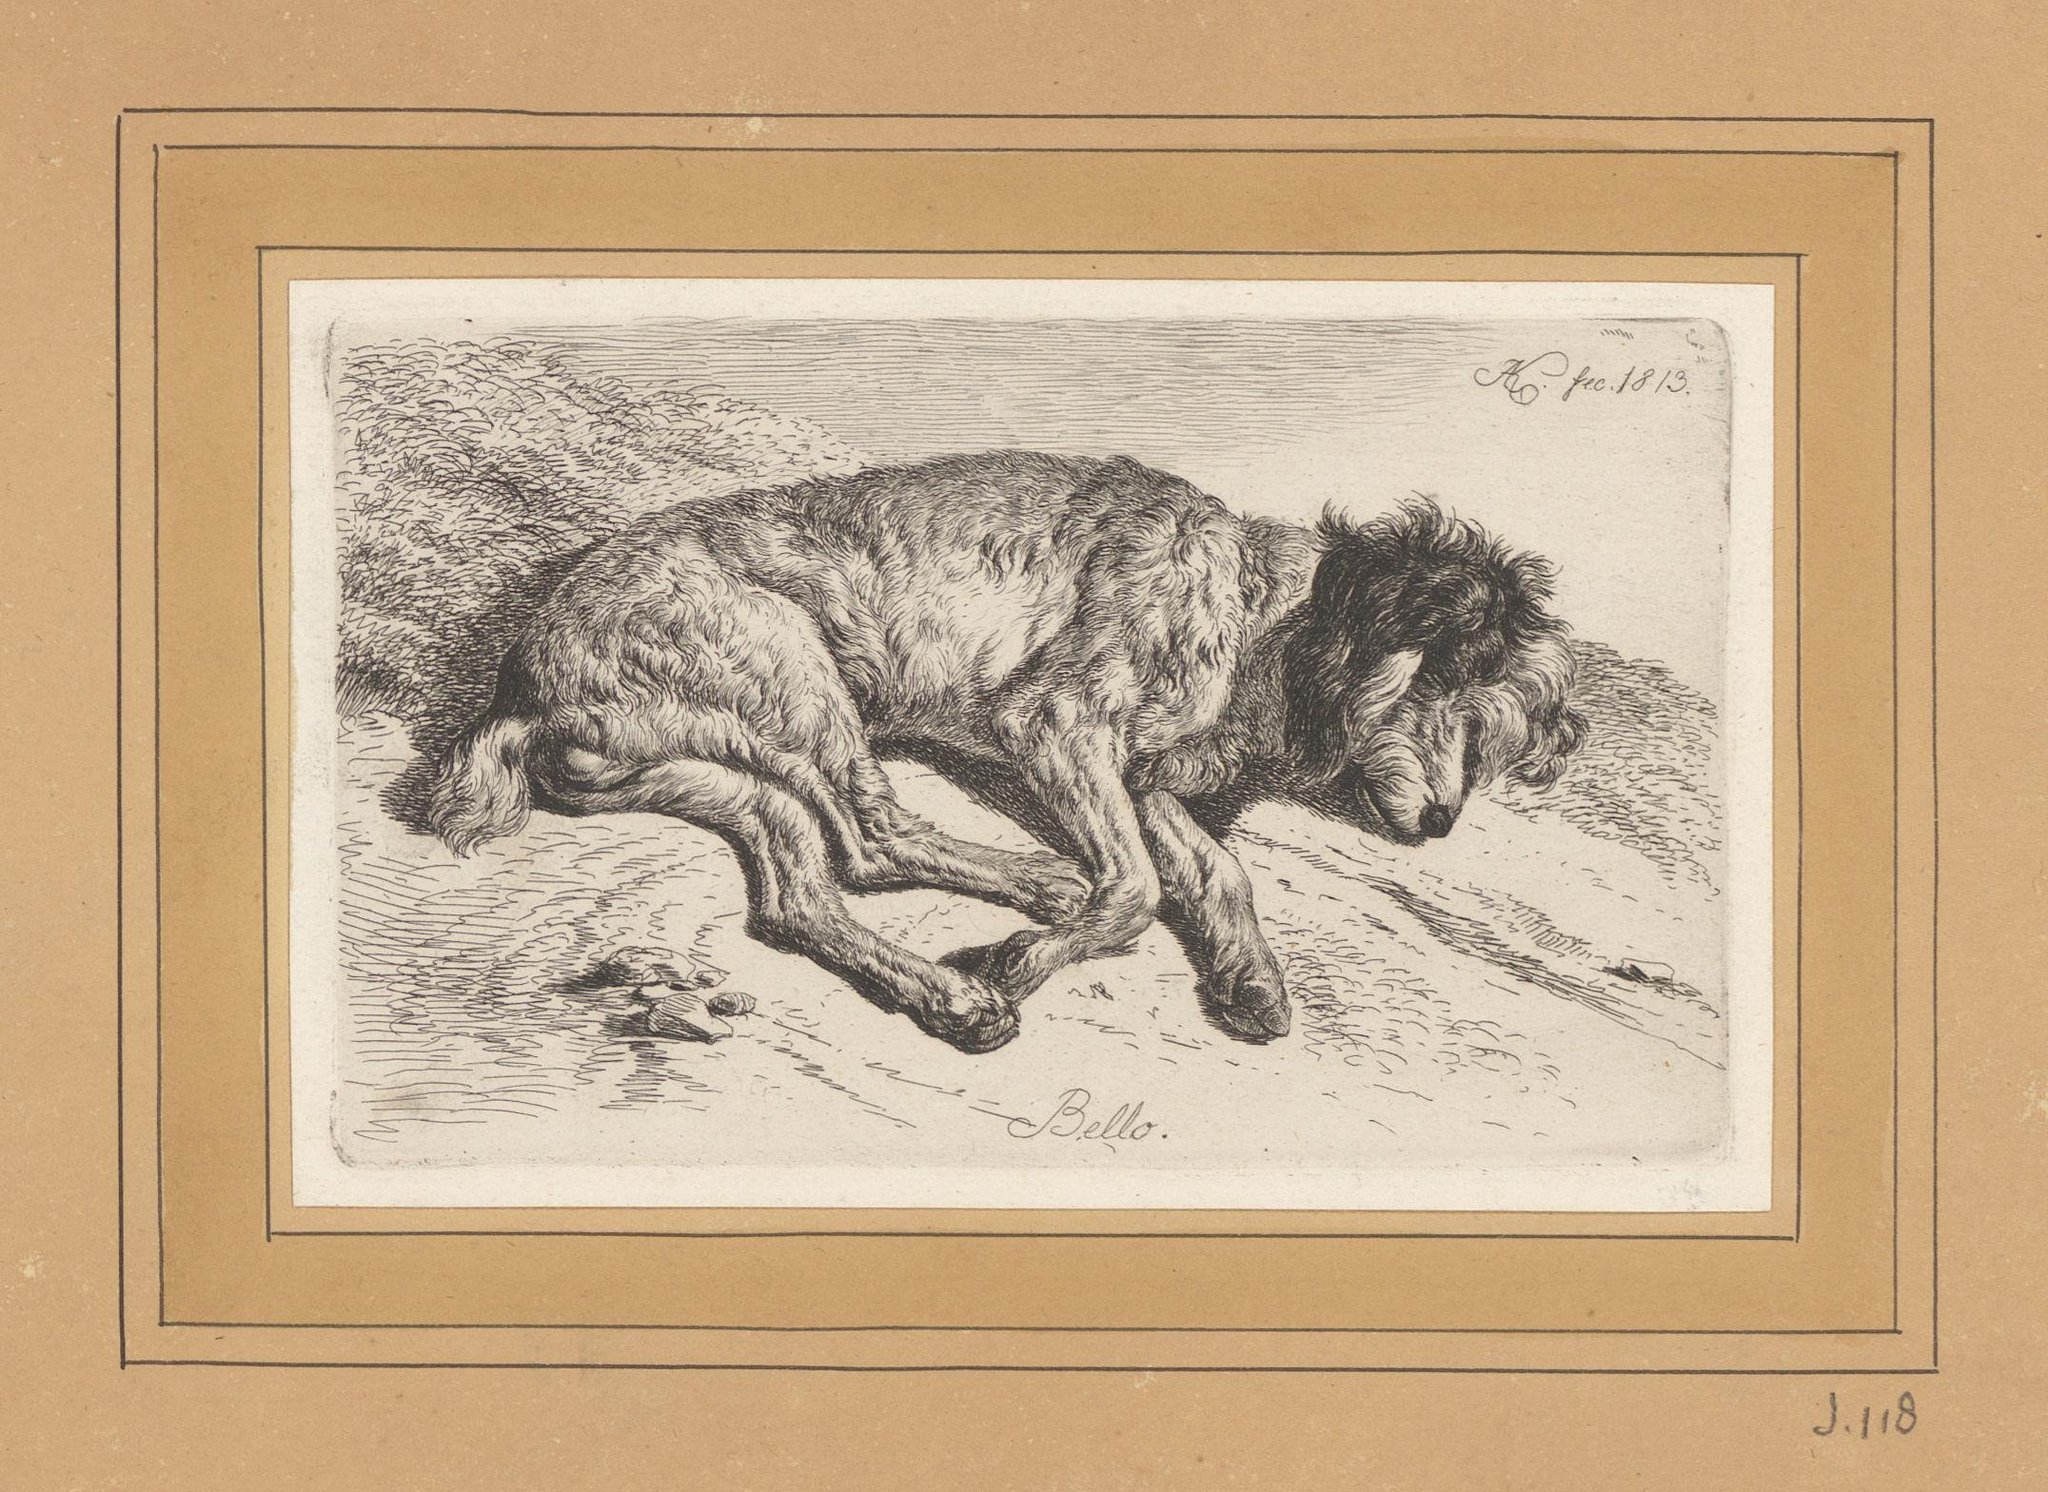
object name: album leaf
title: Slapende hond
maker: johann adam klein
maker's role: draughtsman, print maker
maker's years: 1792-1875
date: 1813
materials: paper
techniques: etching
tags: sleeping on the ground, dog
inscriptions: collector's mark: Lugt 2228, collector's mark: Lugt 2760